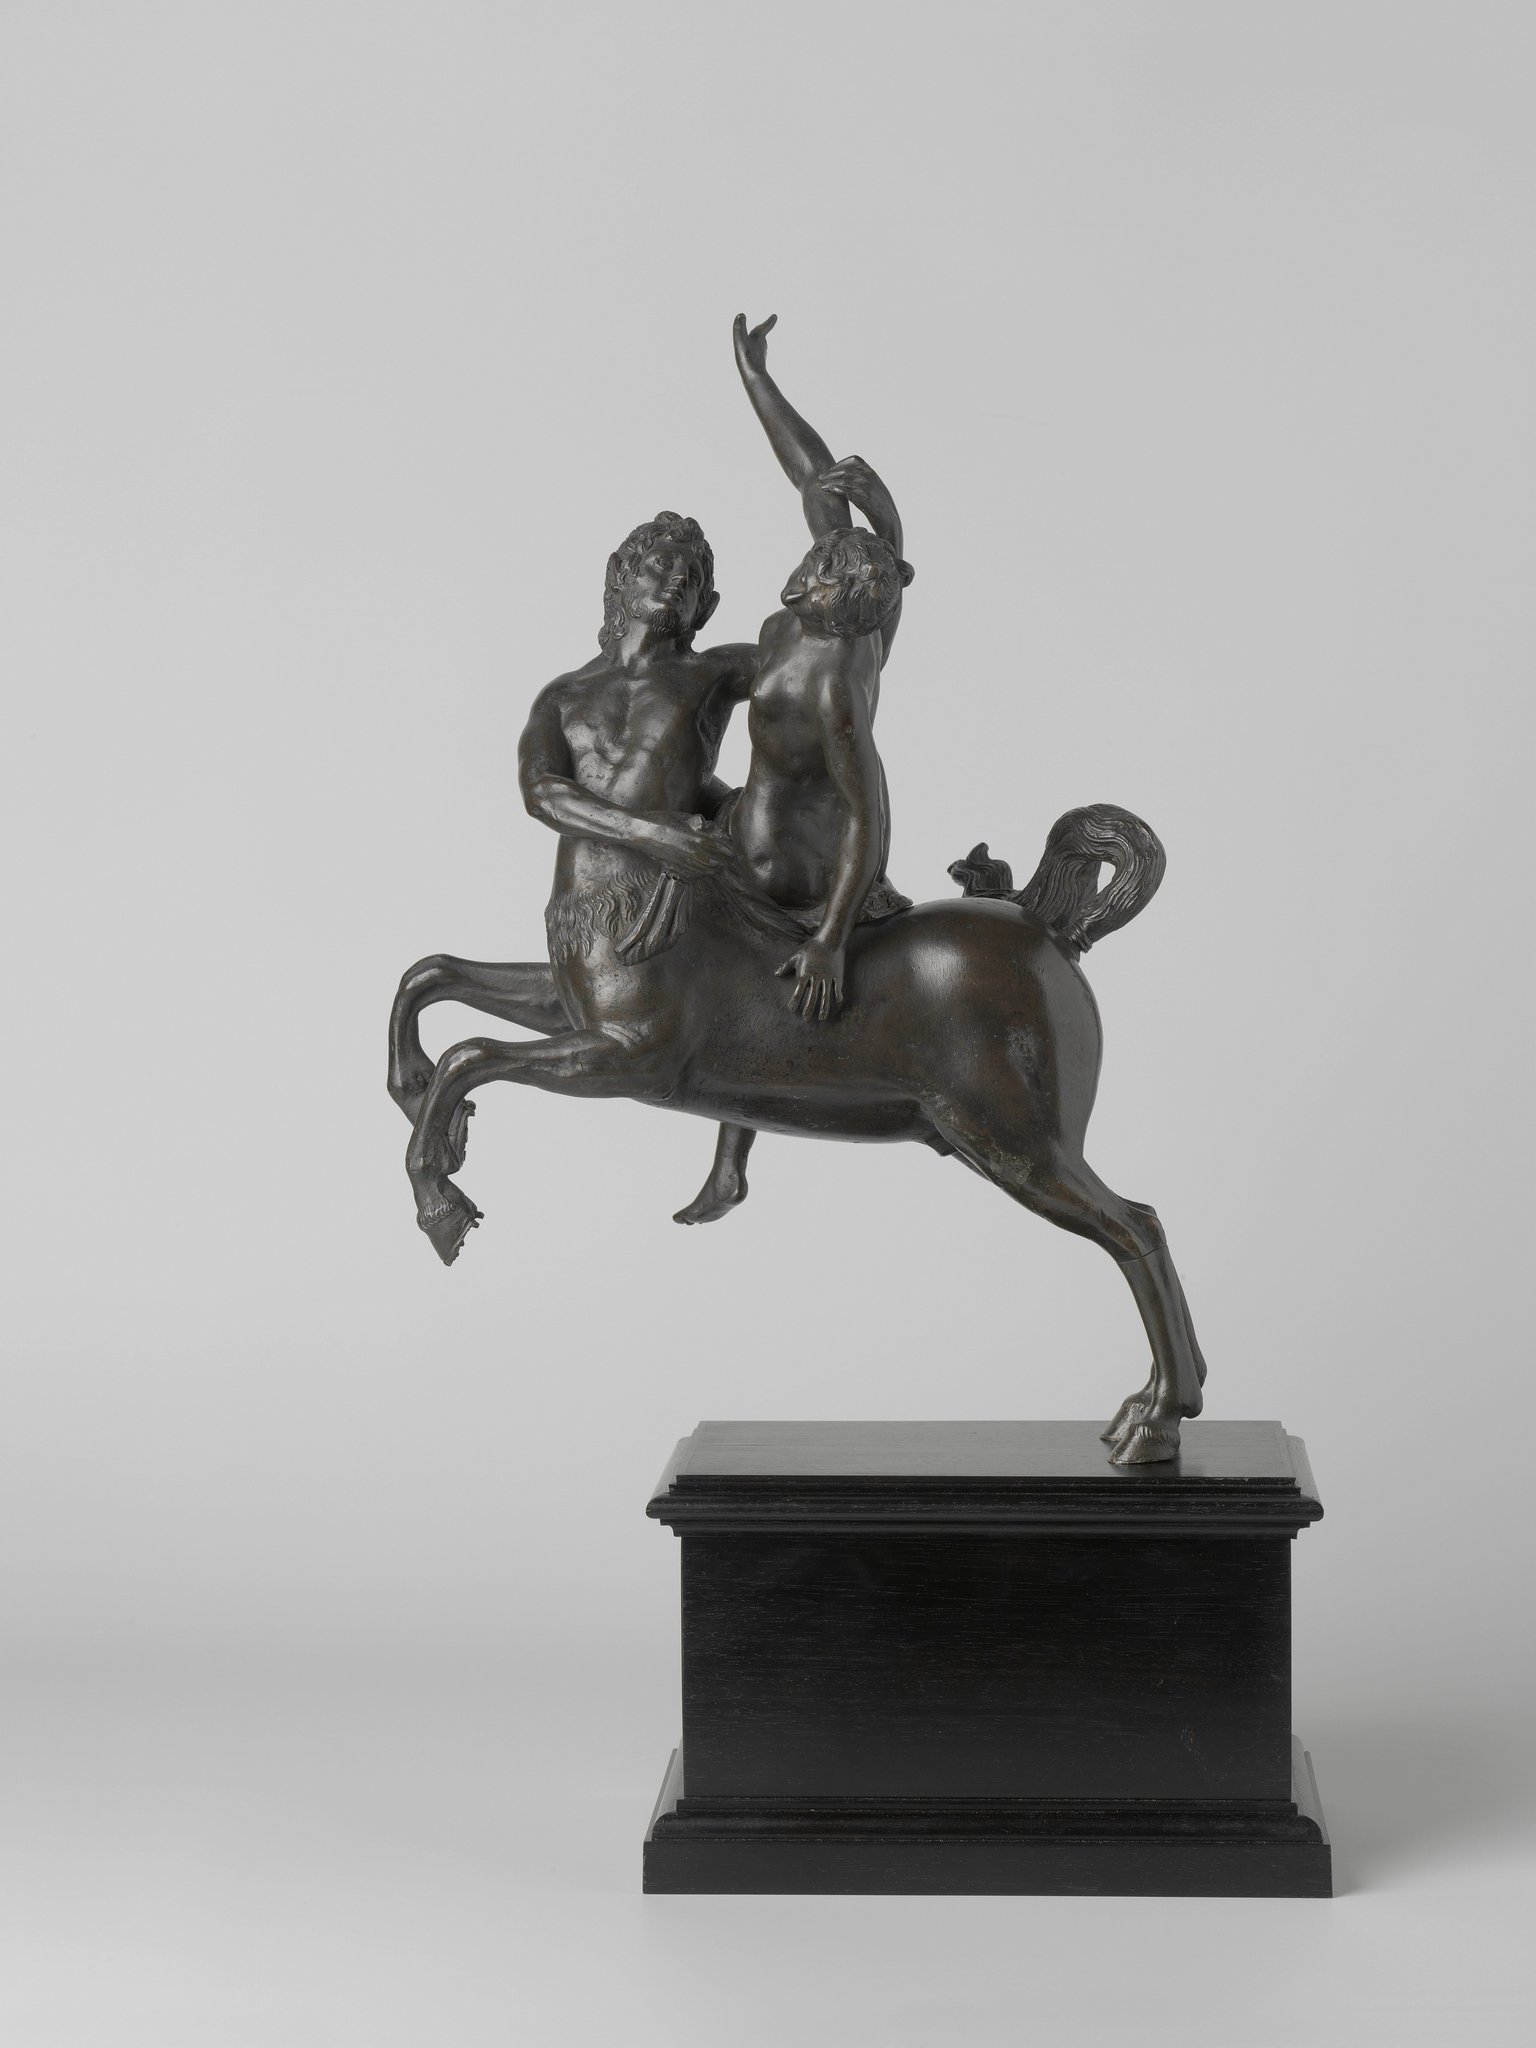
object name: sculpture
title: Nessus and Deianeira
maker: caspar gras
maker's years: 1585-1674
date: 1640-1650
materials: bronze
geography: innsbruck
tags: nessus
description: Attributed to Caspar Gras (1585 - 1674). Nessus abducting Deianeira. Bronze. Innsbruck, c. 1630.